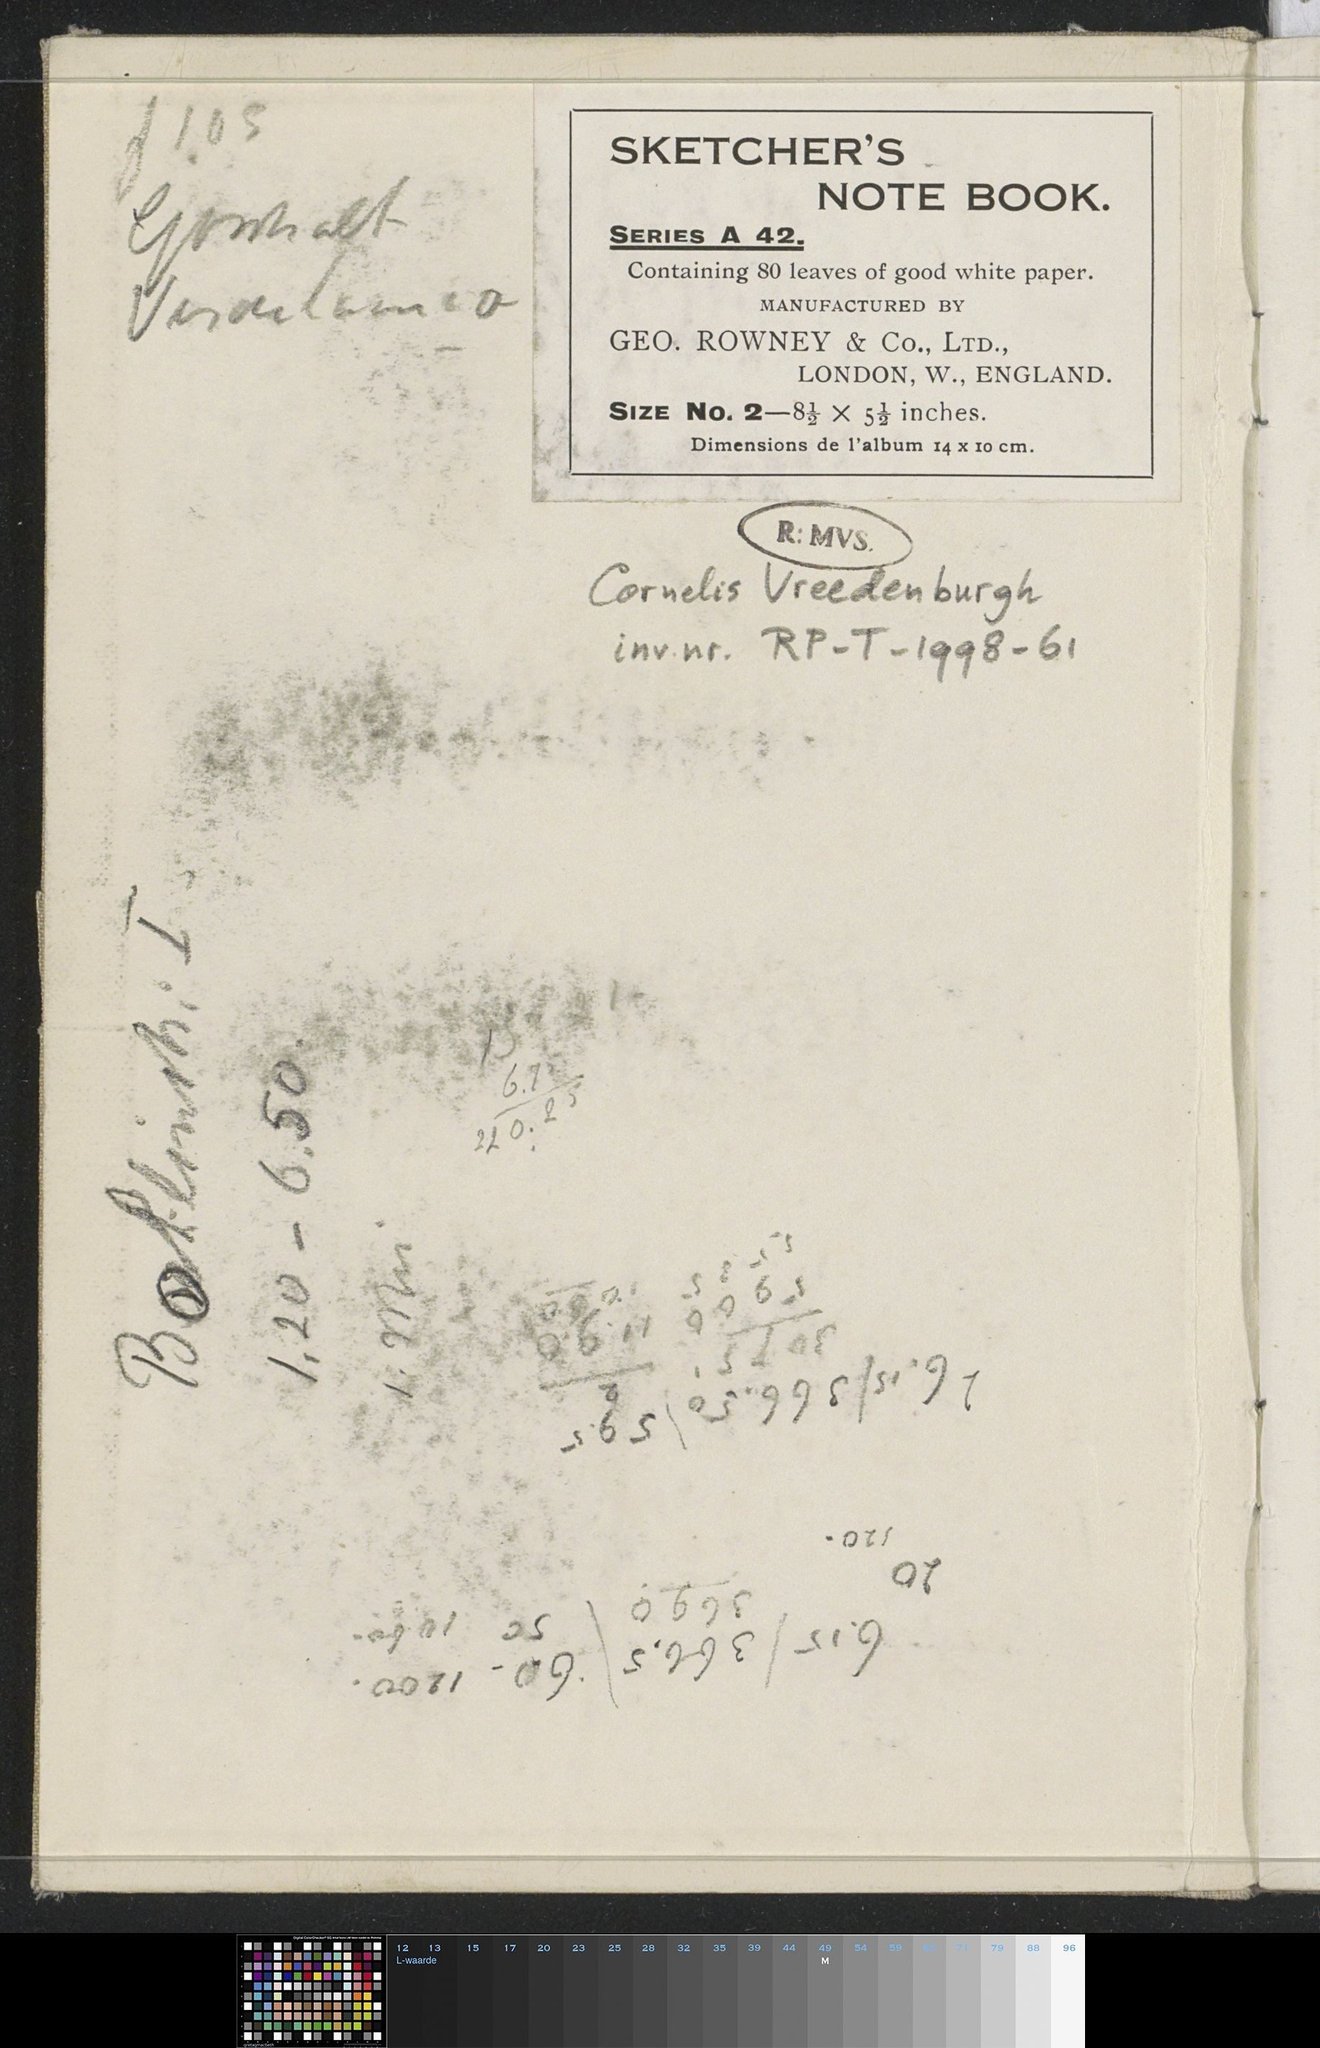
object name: sketchbook leaf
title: Notities en berekeningen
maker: cornelis vreedenburgh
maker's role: draughtsman, print maker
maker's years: 1880-1946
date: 1935-1936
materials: paper, pencil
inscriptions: factory mark: ‘SKETCHER'S/ NOTE BOOK/ SERIES A 42/ containing 80 leaves of good white paper./ MANUFACTURED BY/ GEO. ROWNEY & CO., LONDON, W., ENGLAND/ SIZE No. 2- 8 1/2 x 5 1/2 inches./ Dimensions de l'album 14 x 10 cm.’, annotation: ‘f 1.05/ [...]alt/ Va[...]laan 2a/Boklinsch:I/ 1.20 -6.50 [...]’, collector's mark: Lugt 2228a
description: Voorste schutblad uit een schetsboek met 73 bladen.